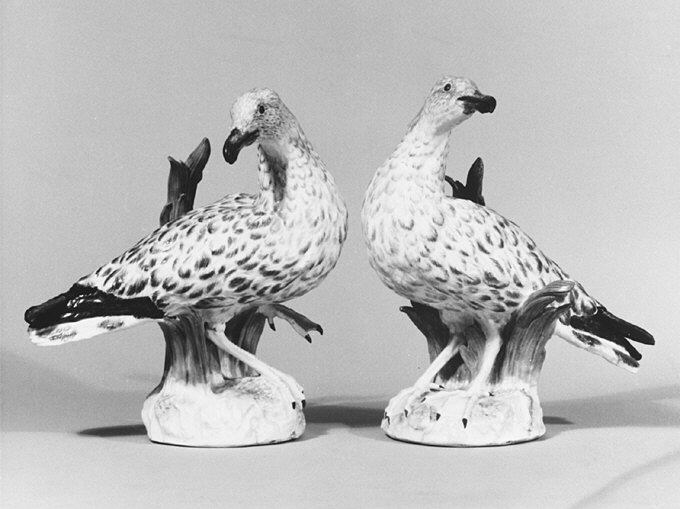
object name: figure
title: Herring gull (one of a pair)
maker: meissen manufactory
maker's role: manufactory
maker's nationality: german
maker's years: 1710-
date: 1750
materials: hard paste porcelain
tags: birds